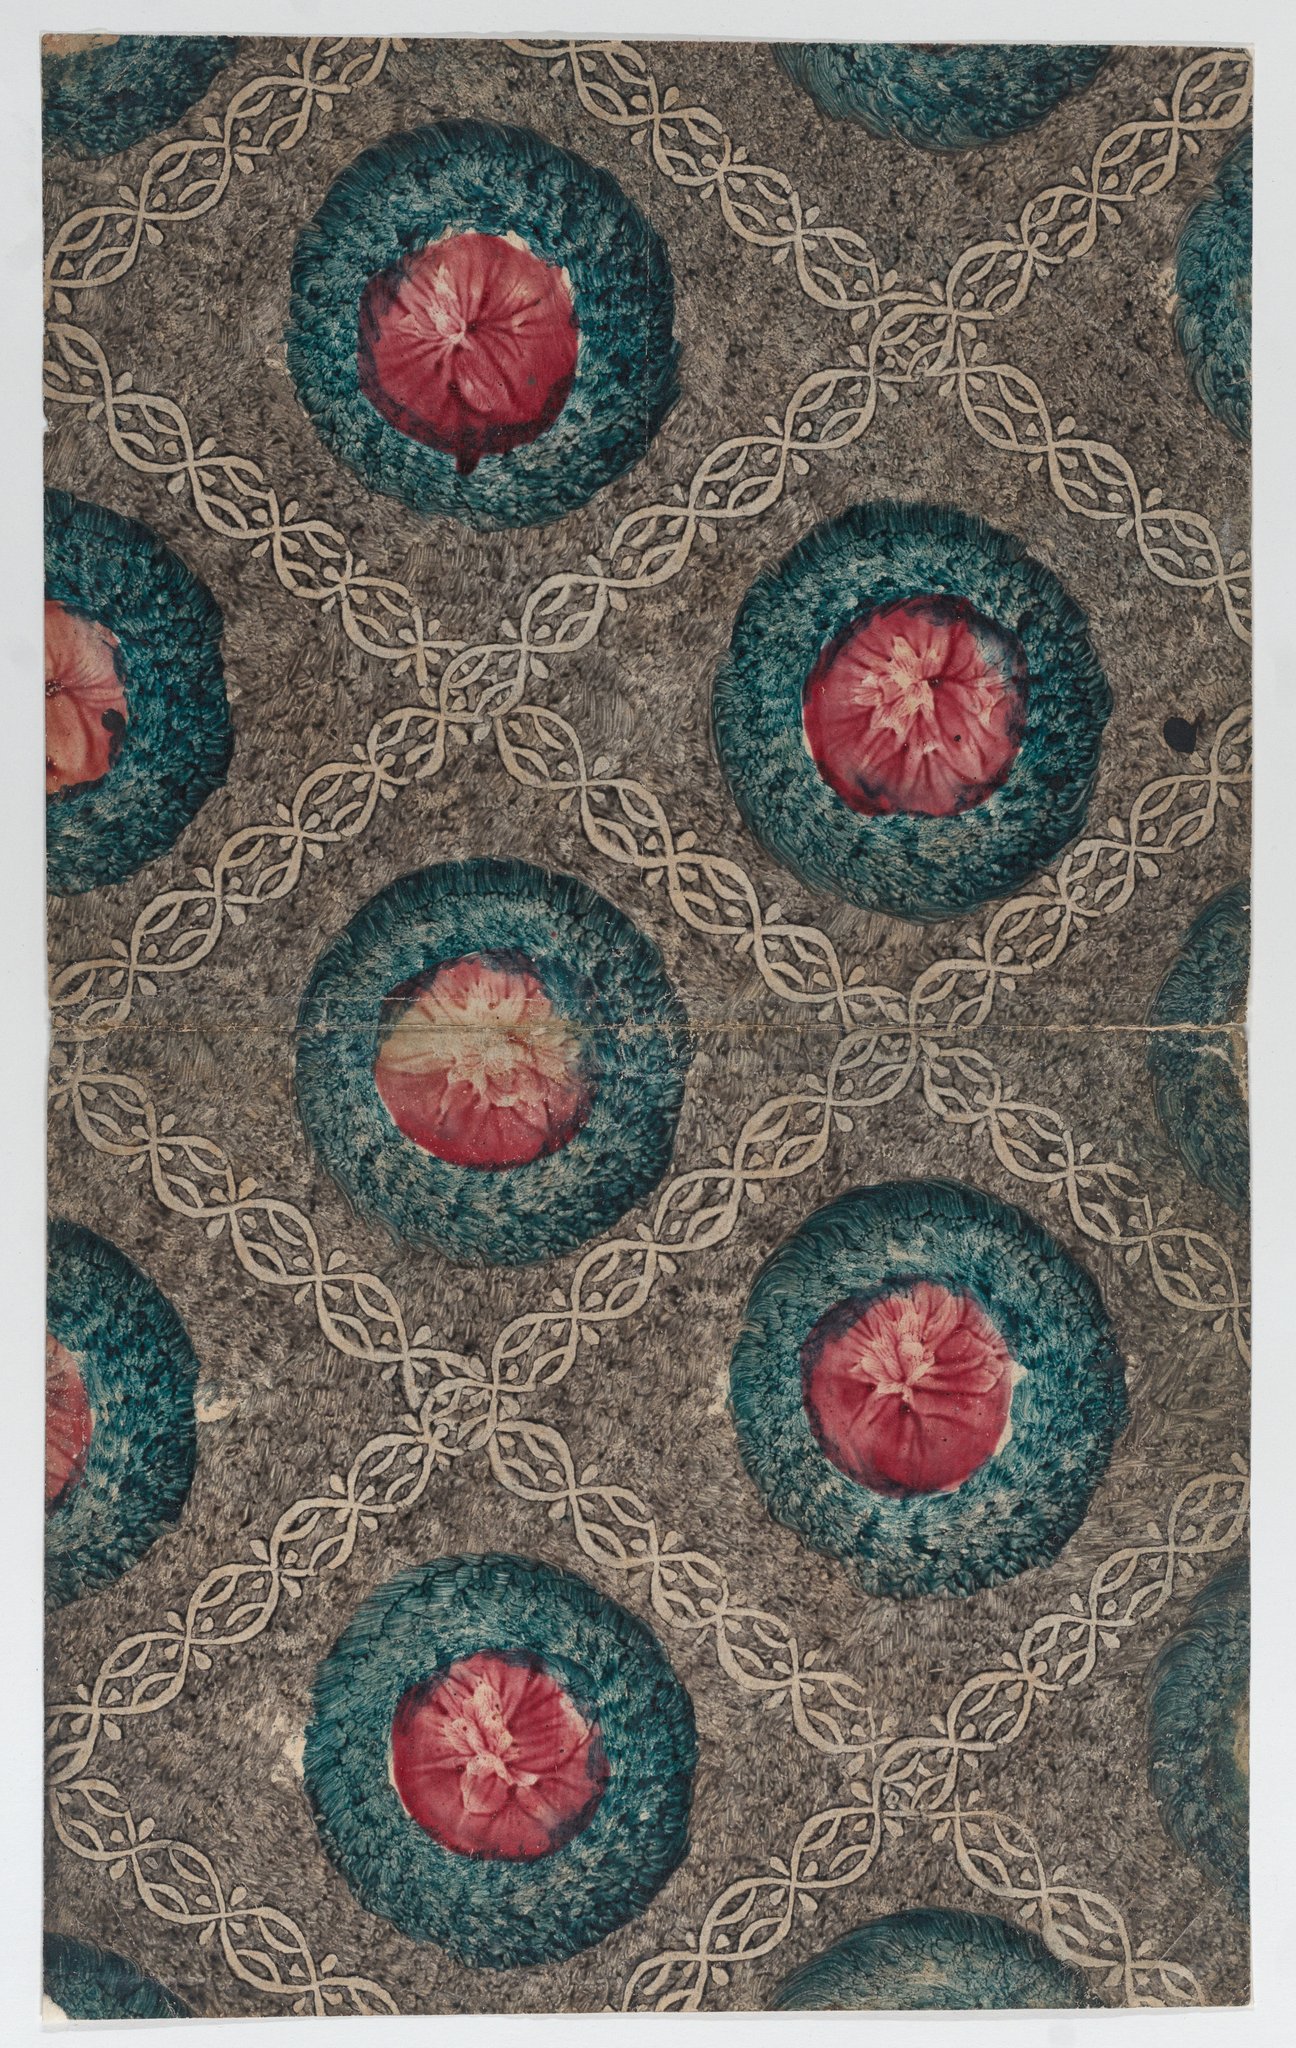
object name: print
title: Book cover with circular designs and ornamental diagonal pattern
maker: Anonymous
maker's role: artist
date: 1801-1900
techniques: relief print